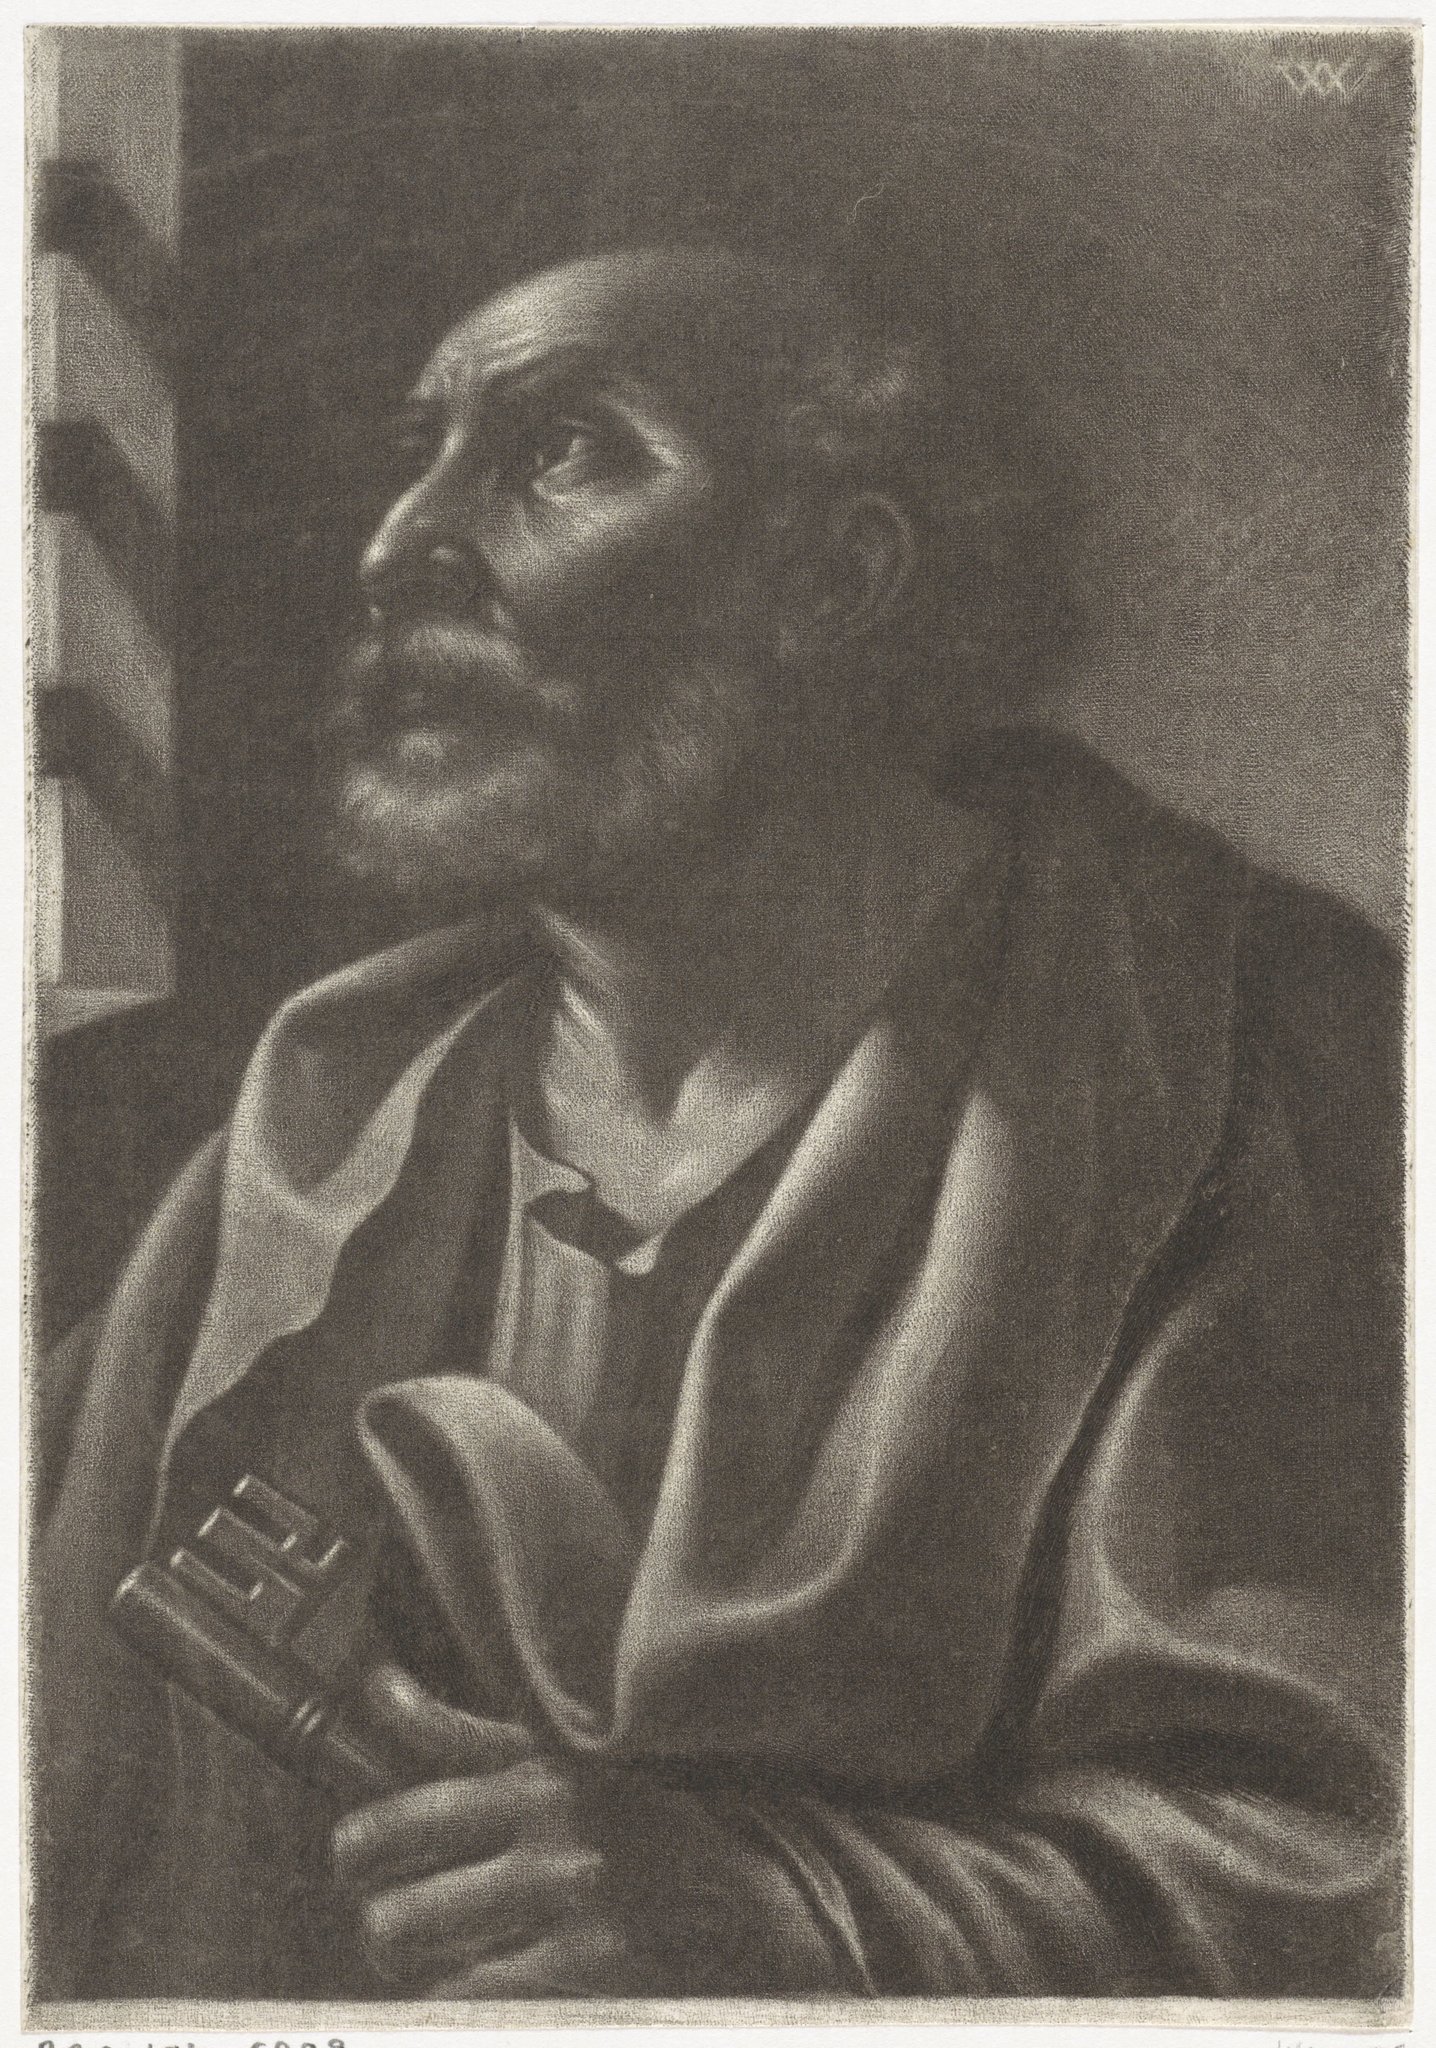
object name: print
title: Apostel Petrus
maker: wallerant vaillant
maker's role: draughtsman, painter, print maker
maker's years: 1623-1677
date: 1658-1677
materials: paper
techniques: mezzotint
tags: the apostle peter, first bishop of rome; possible attributes: book, cock, (upturned) cross, (triple) crozier, fish, key, scroll, ship, tiara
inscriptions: collector's mark: Lugt 2228, collector's mark: Lugt 2036